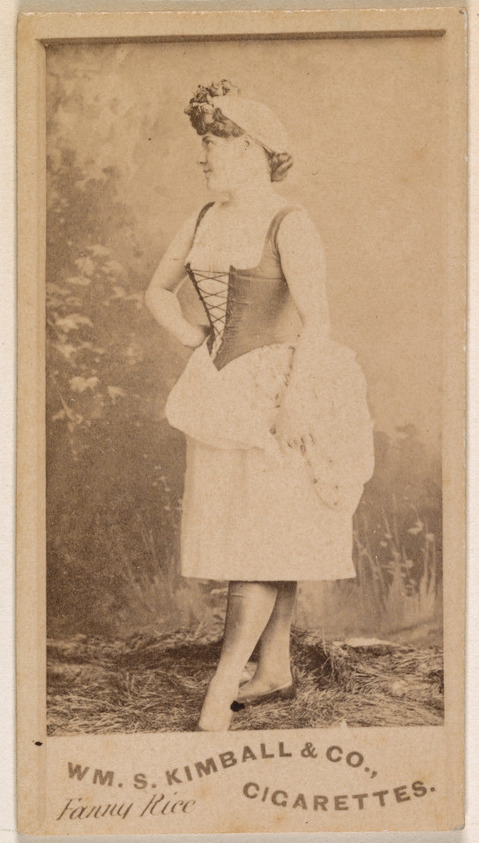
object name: photograph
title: Fanny Rice, from the Actresses series (N203) issued by Wm. S. Kimball & Co.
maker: william s. kimball & company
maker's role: publisher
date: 1889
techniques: color lithograph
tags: profiles,women,actresses